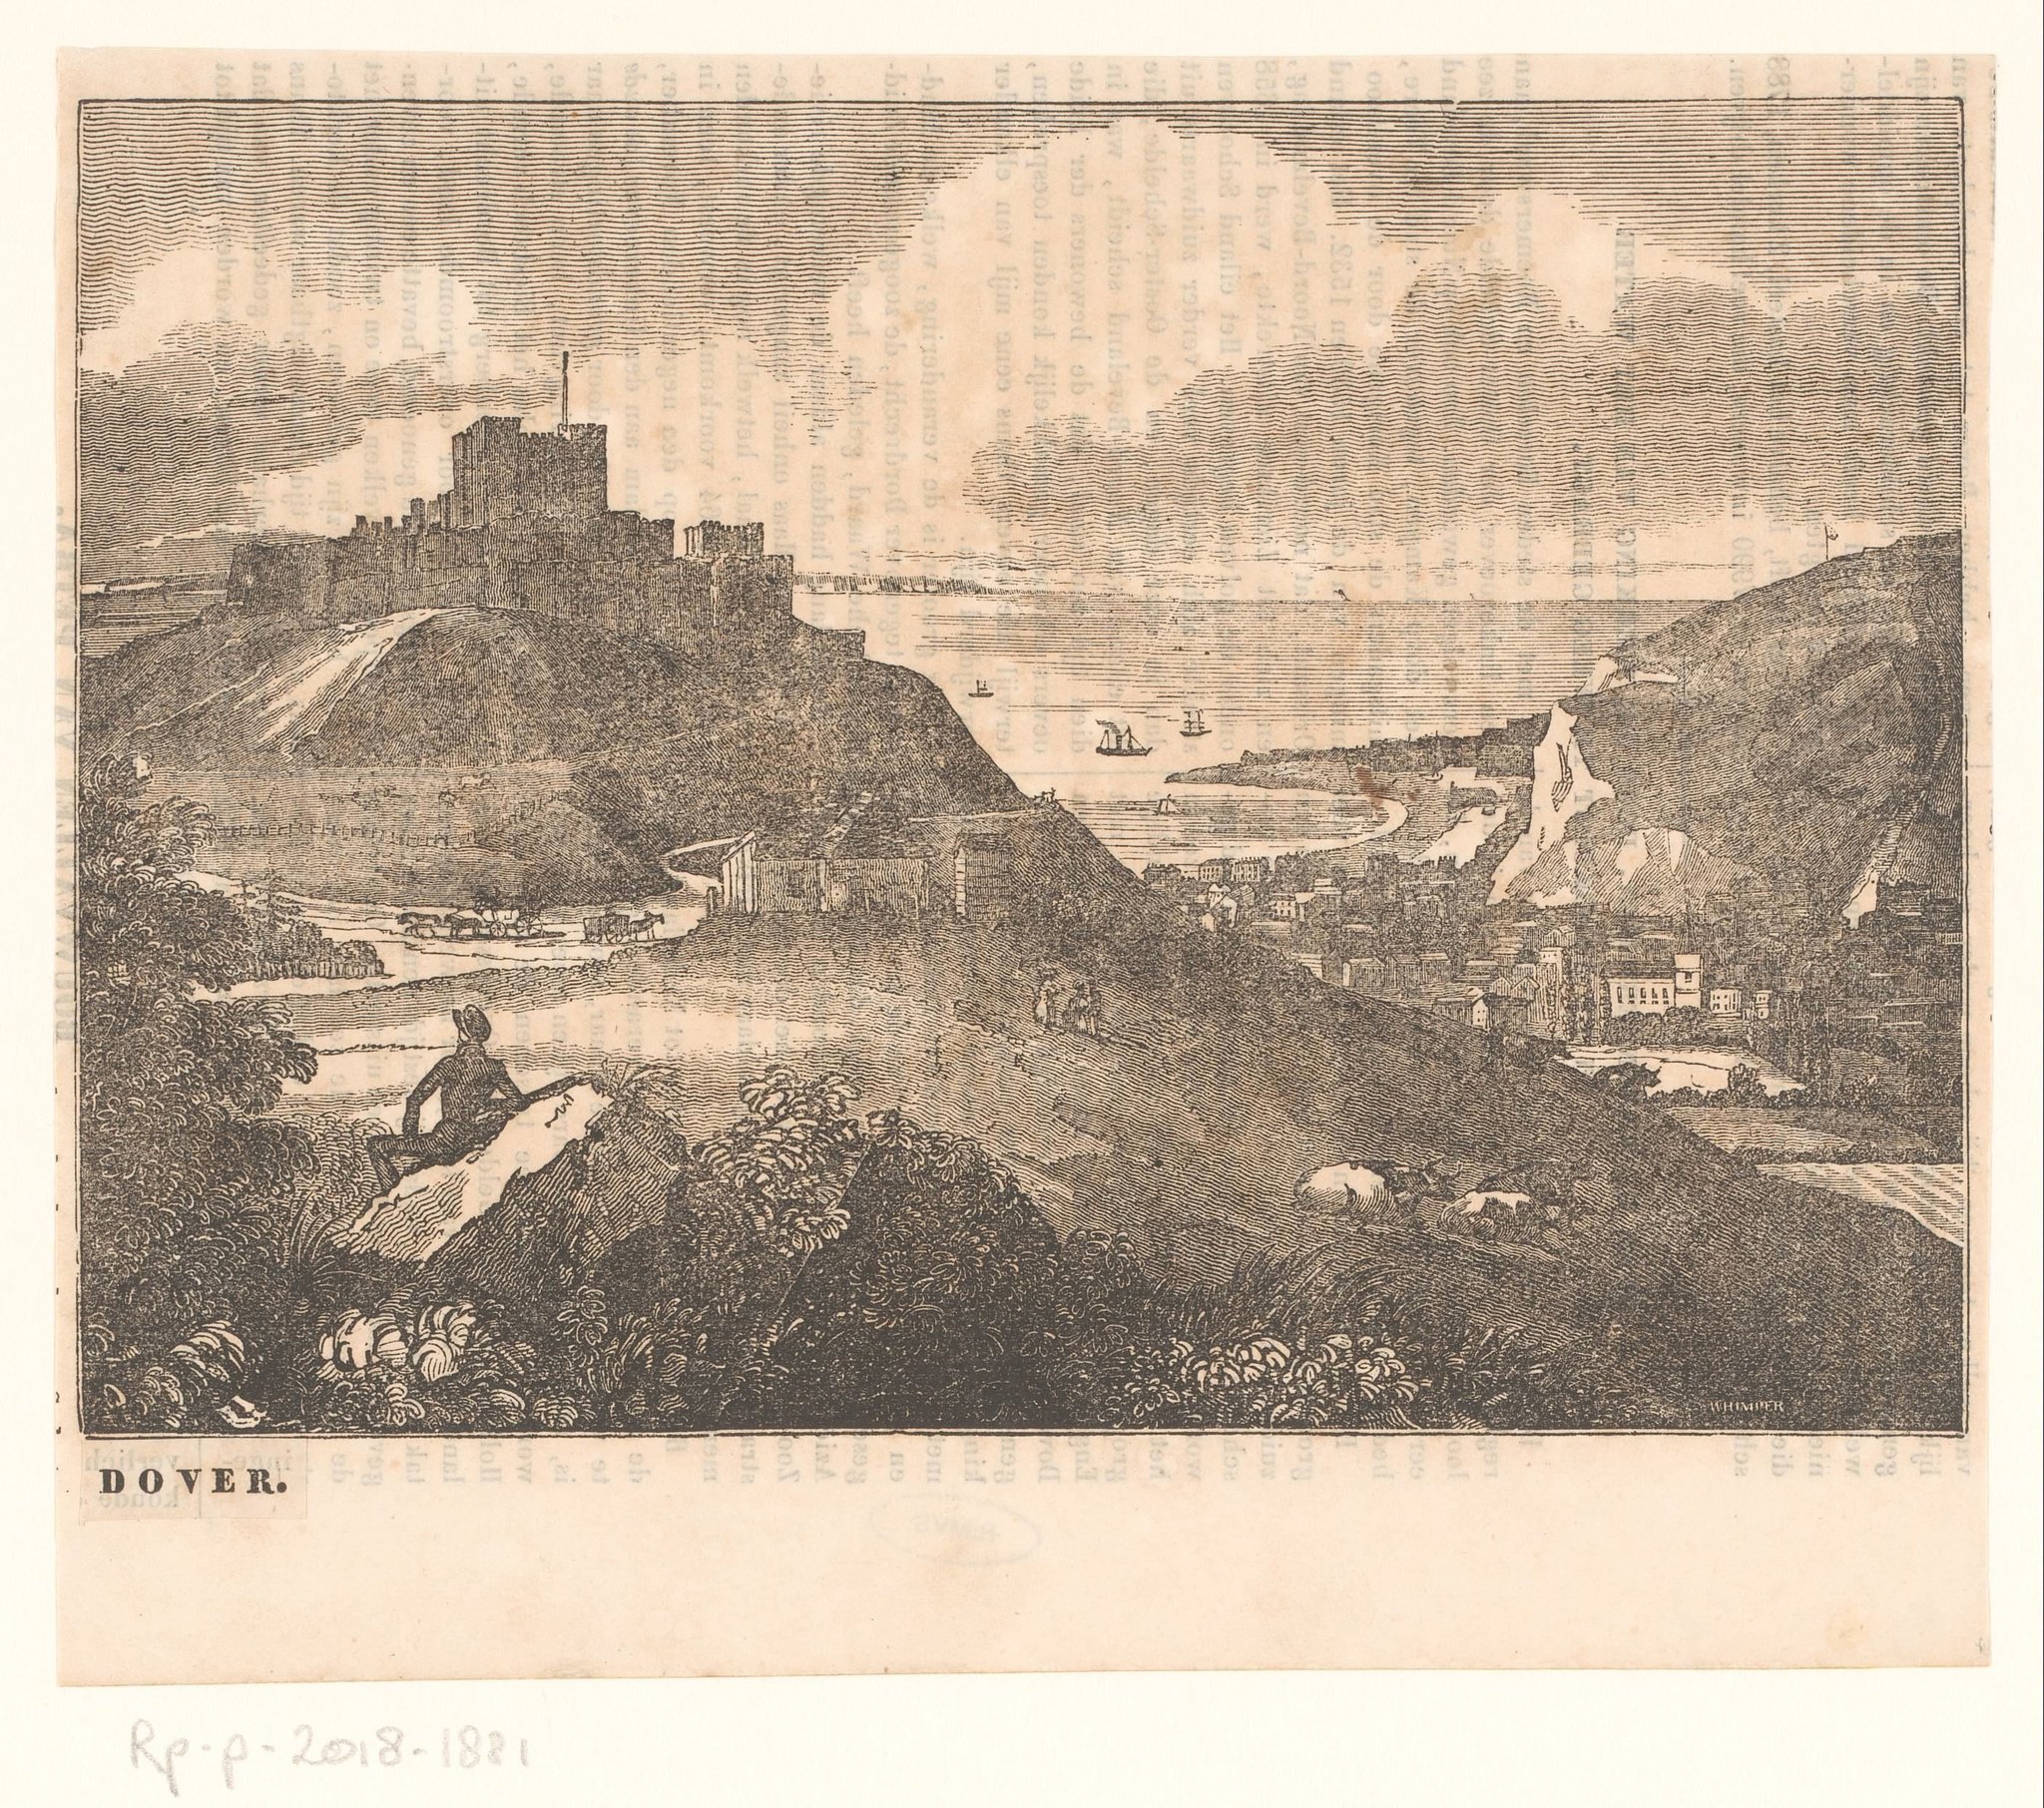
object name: print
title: Gezicht op Dover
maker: Anonymous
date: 1837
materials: paper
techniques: letterpress printing, engraving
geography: amsterdam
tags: prospect of city, town panorama, silhouette of city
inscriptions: collector's mark: Lugt 2228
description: Prent gebruikt in: Nederlandsch Magazijn ter verspreiding van algemeene en nuttige kundigheden. Amsterdam: Gebroeders Diederichs, 1837.